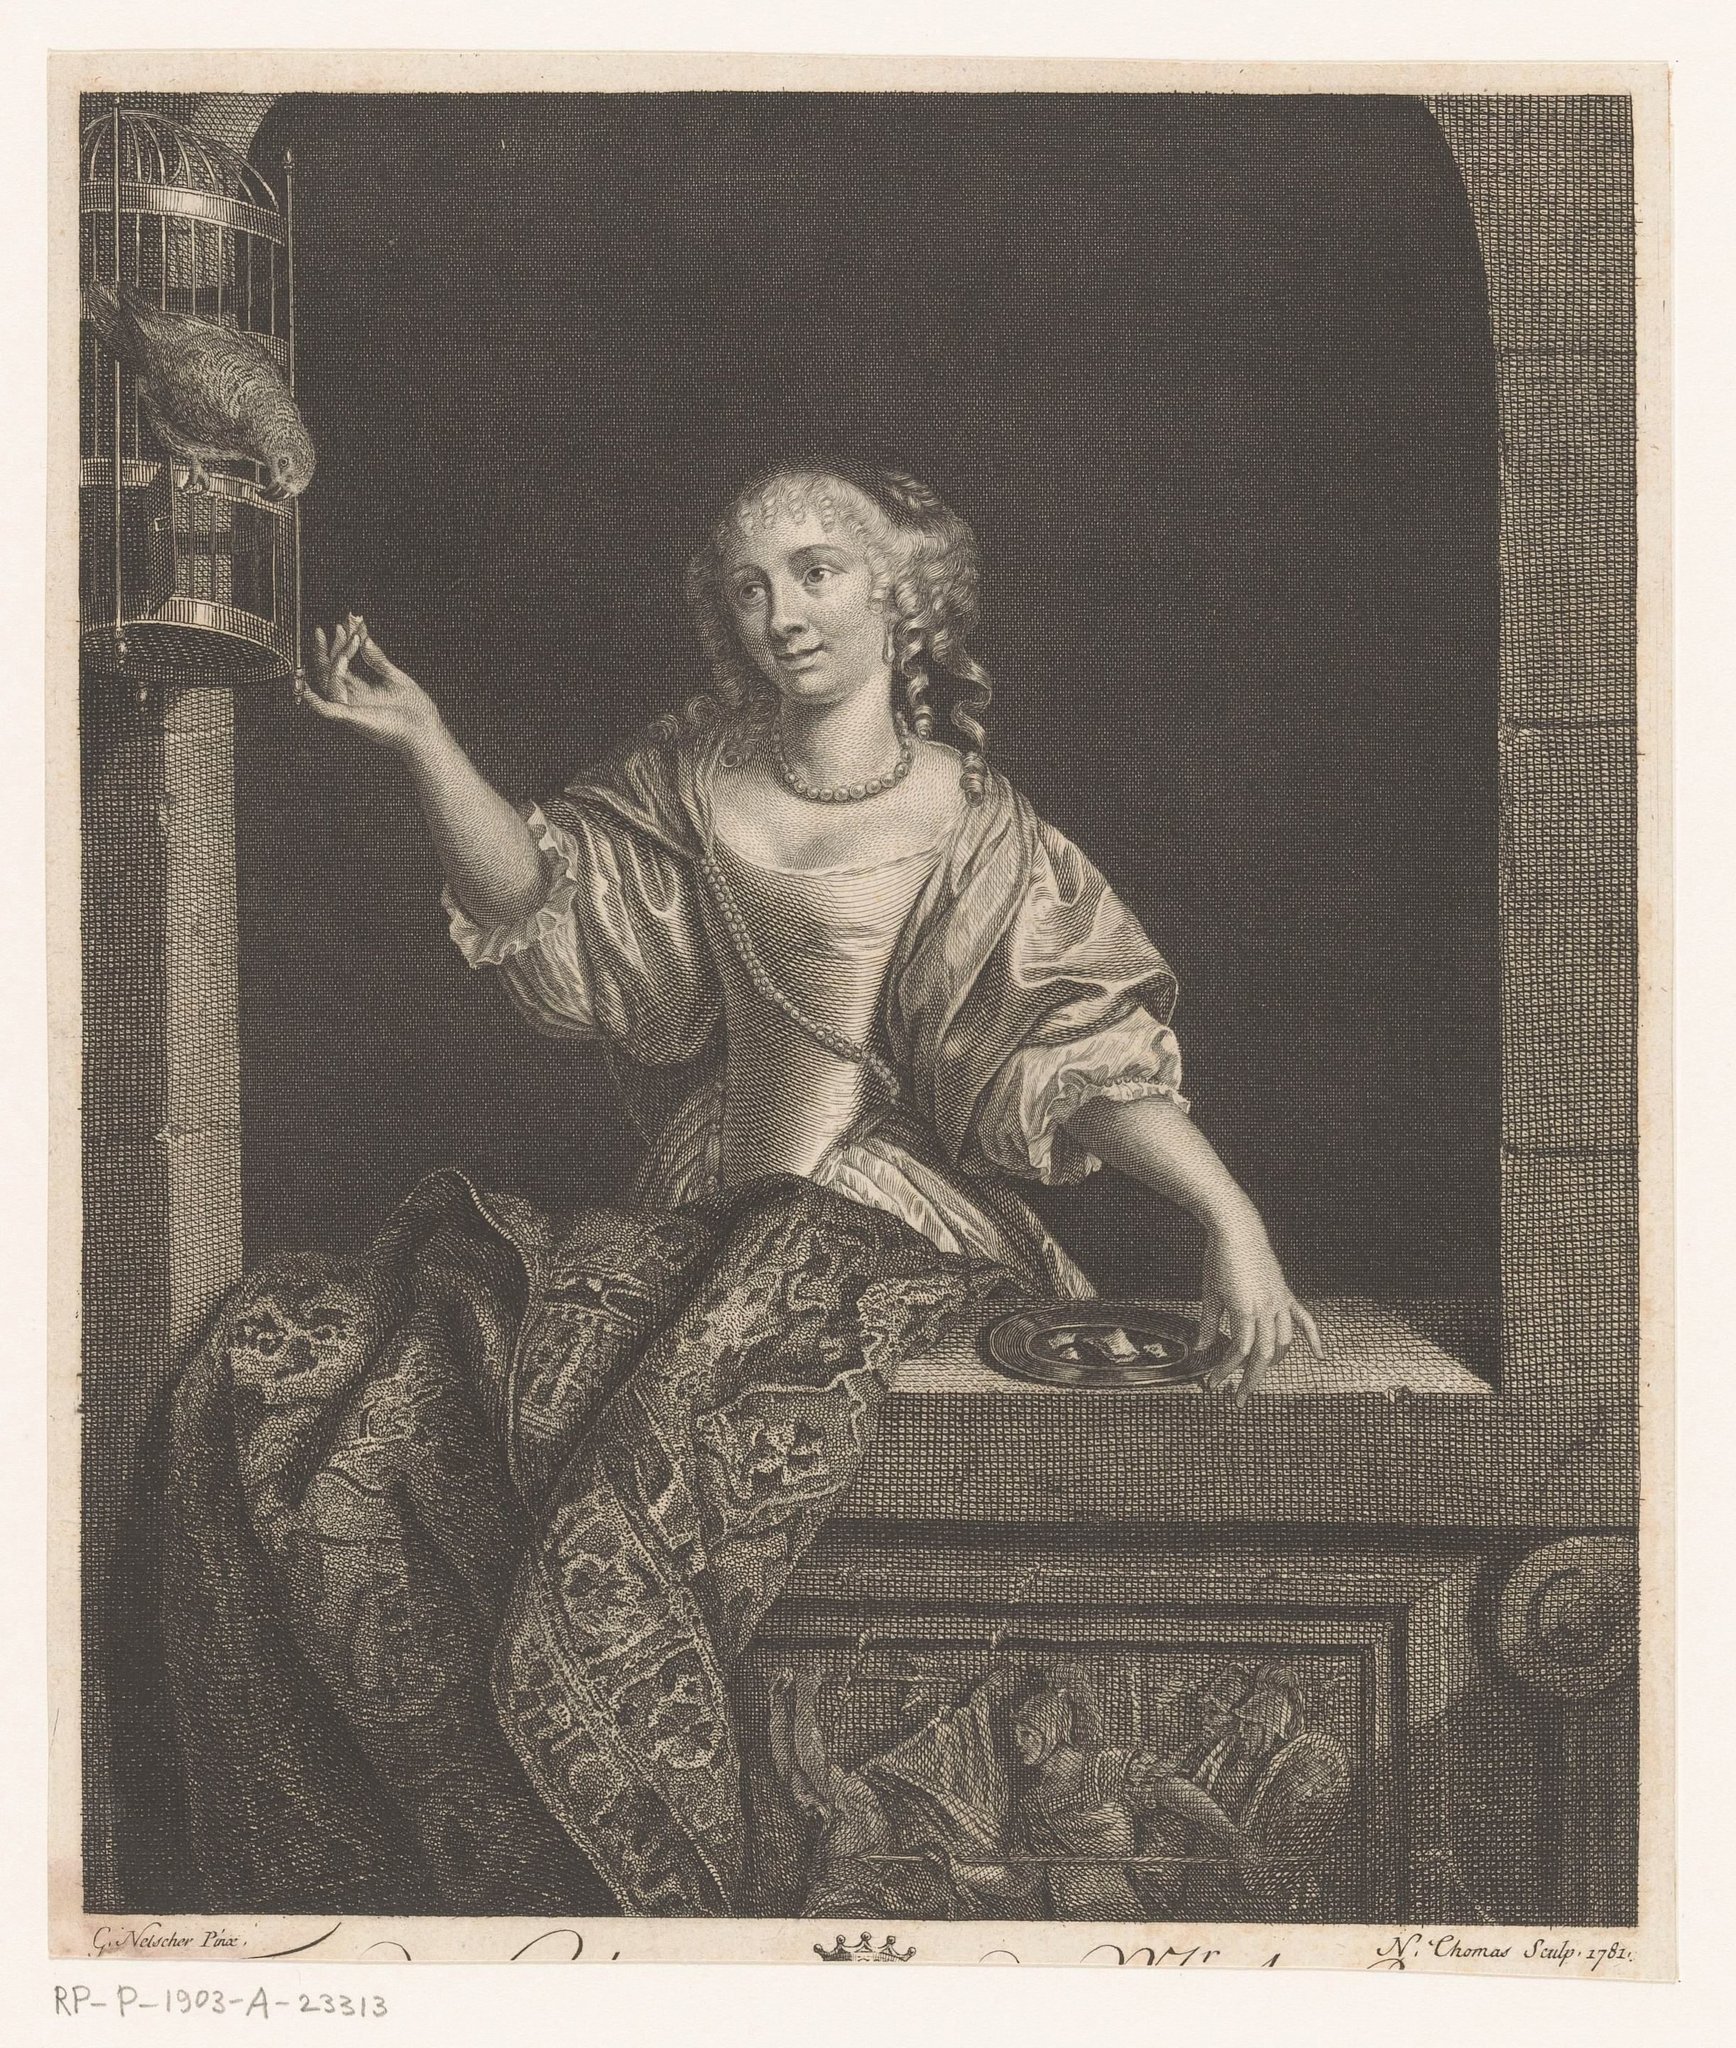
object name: print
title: Meisje in een venster voert een papegaai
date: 1781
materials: paper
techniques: engraving, etching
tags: giving food, adolescent, young woman, maiden, ornamental birds: parrot, human figure at (open) window, seen from outside - aa - feigned window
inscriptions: collector's mark: Lugt 2228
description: Het schilderij door Netscher werd in 1664 geschilderd en bevindt zich in het Columbus Museum of Art, te Ohio, inv.nr. 1978.018. Op het schilderij is naast de jonge vrouw nog een man met een aap weergegeven.